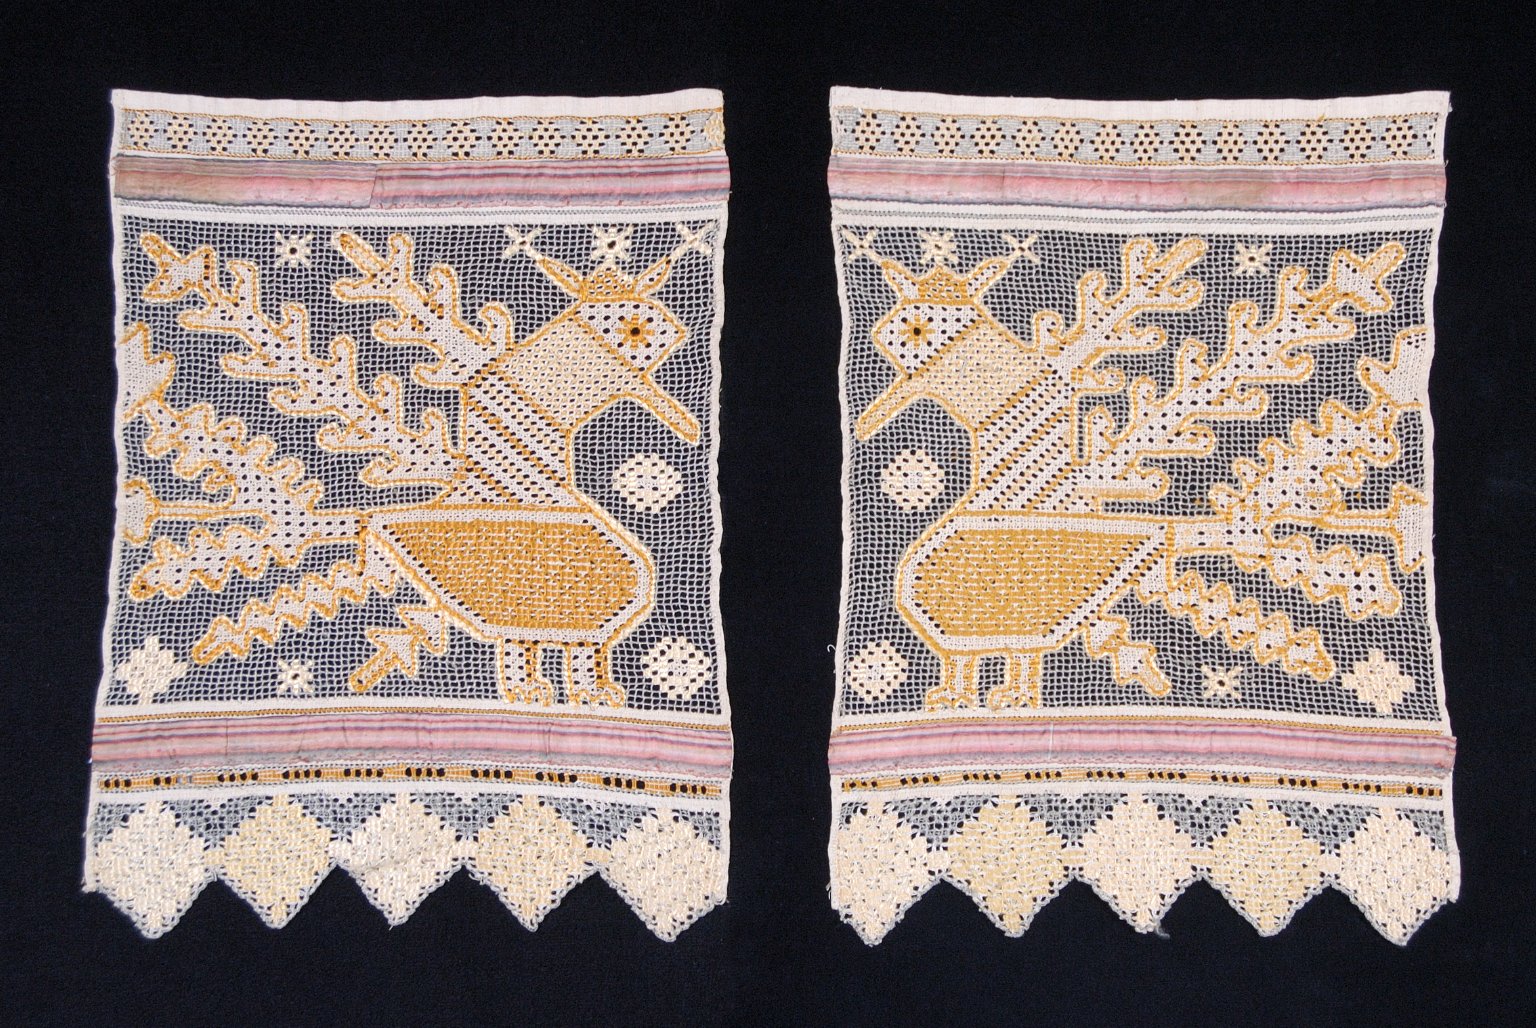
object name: border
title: Towel borders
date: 1800-1850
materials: linen, silk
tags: birds